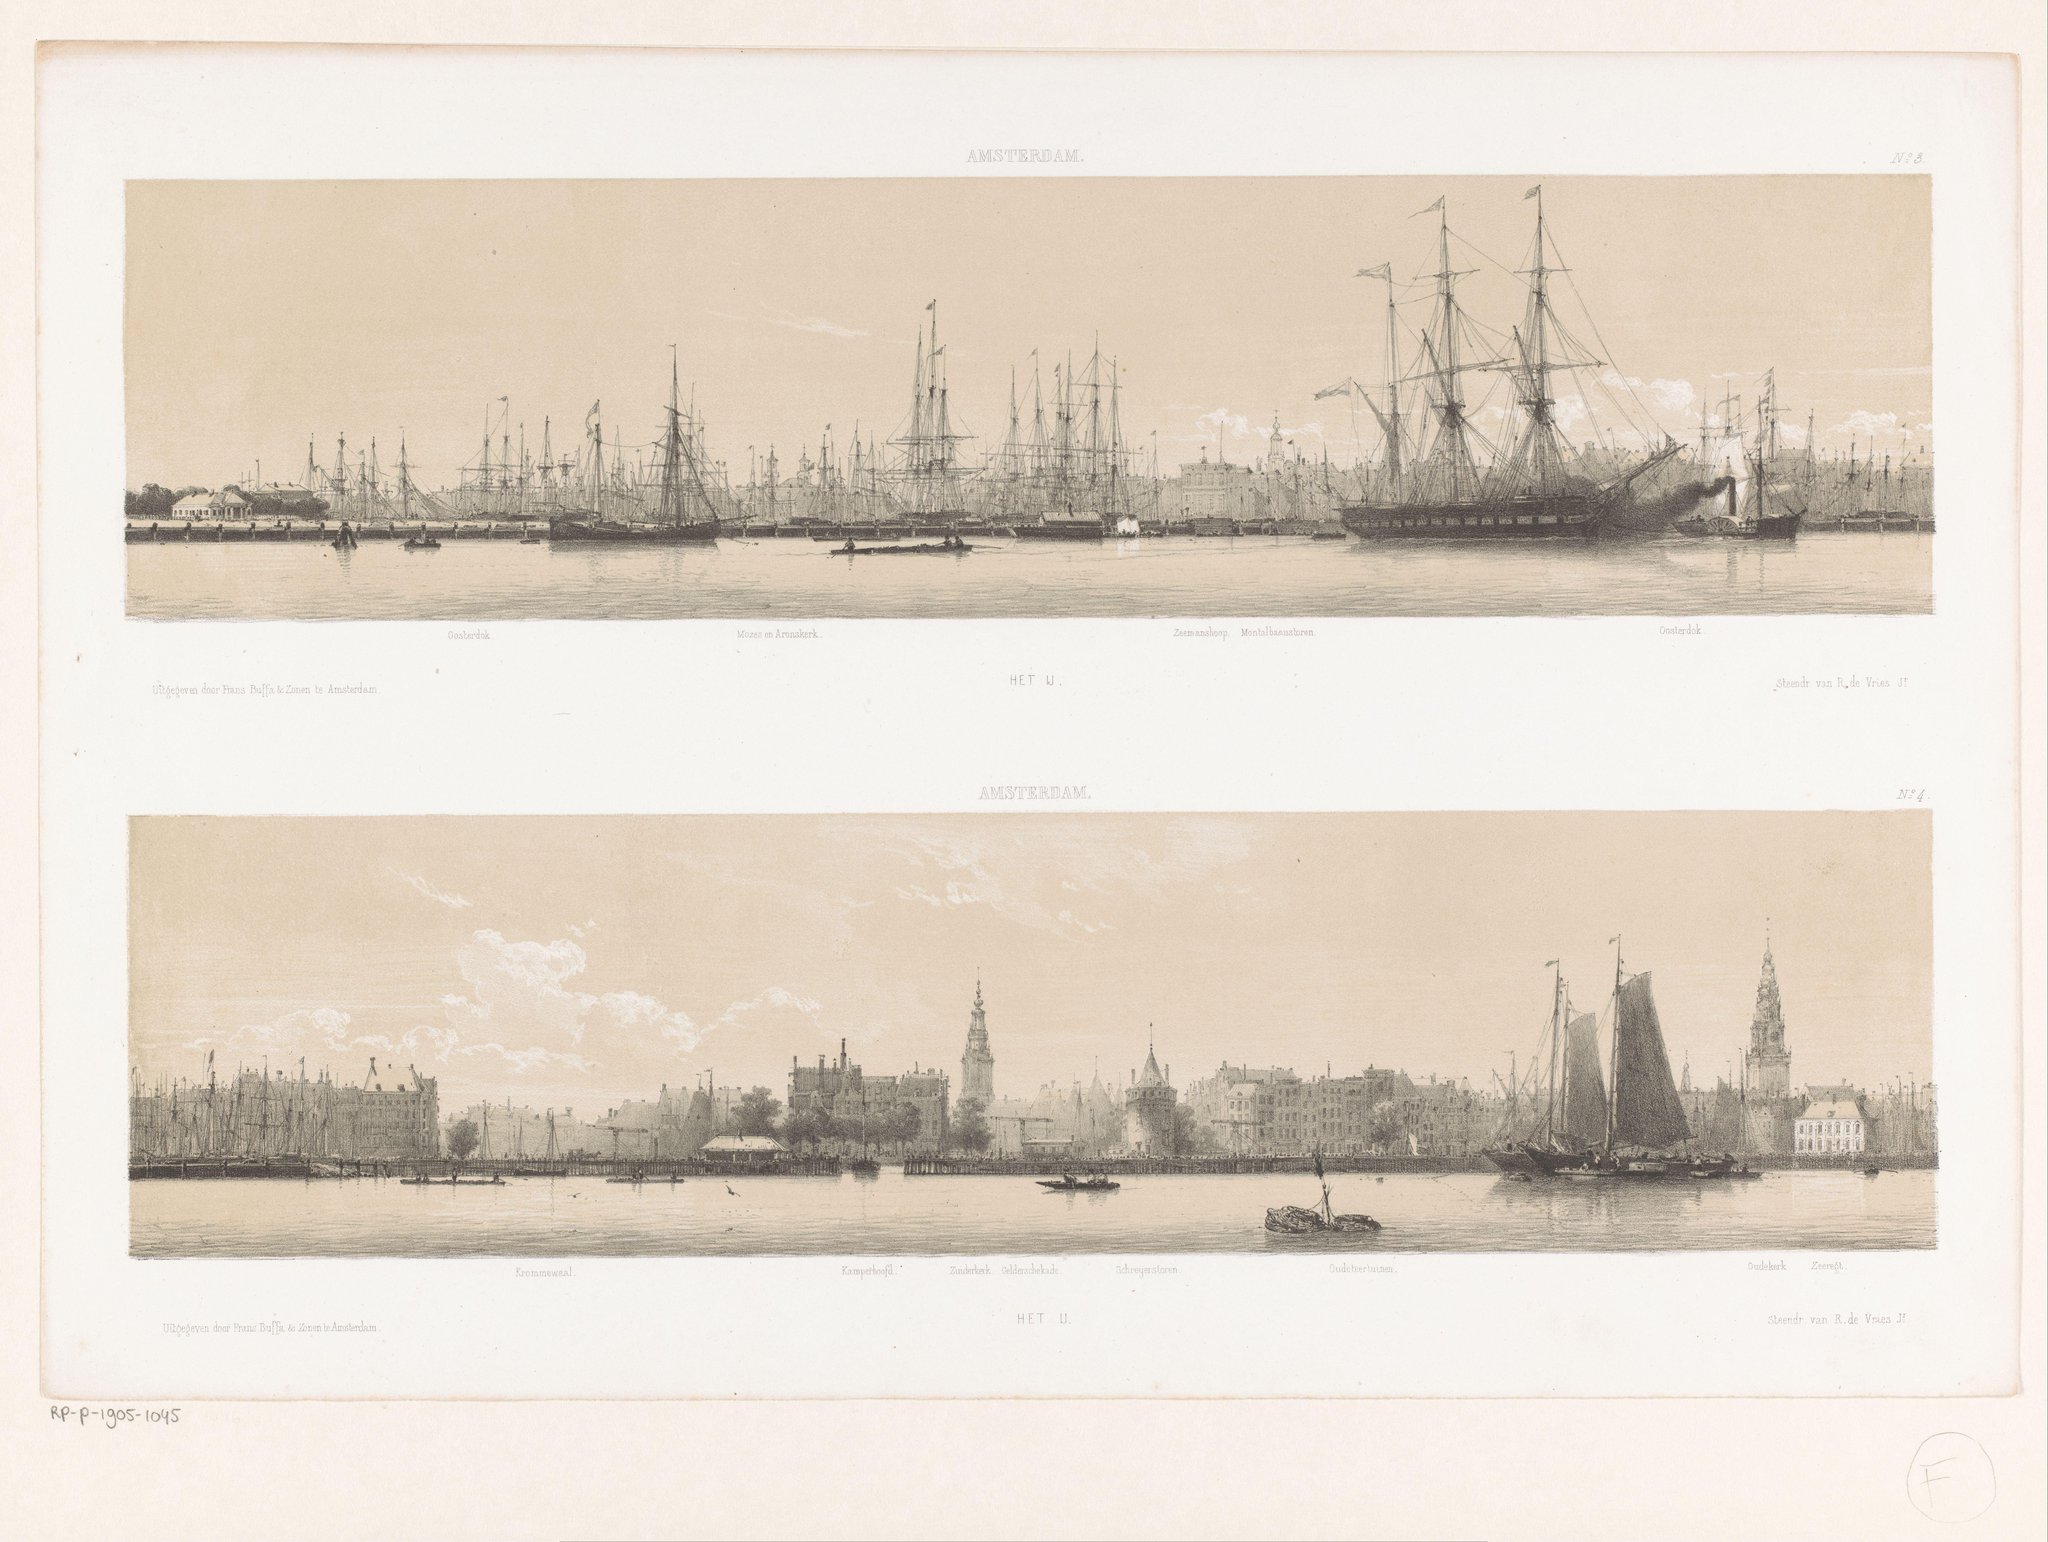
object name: print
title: Profiel van Amsterdam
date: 1860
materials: paper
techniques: tone lithography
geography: amsterdam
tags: prospect of city, town panorama, silhouette of city, amsterdam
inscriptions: collector's mark: Lugt 2228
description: De stad is vanaf het IJ gezien. In het bovenste profiel zijn het Oosterdok, de Mozes en Aronkerk, Zeemanshoop en de Montalbaanstoren afgebeeld. Het tweede profiel daaronder gaat door met de Krommewaal, het Kamperhoofd, de Zuiderkerk, de Gelderse kade, de Schrijerstoren, de Oude Teertuinen, de Oude Kerk en het Zeeregt. Beiden profielen zijn rechtsboven genummerd.